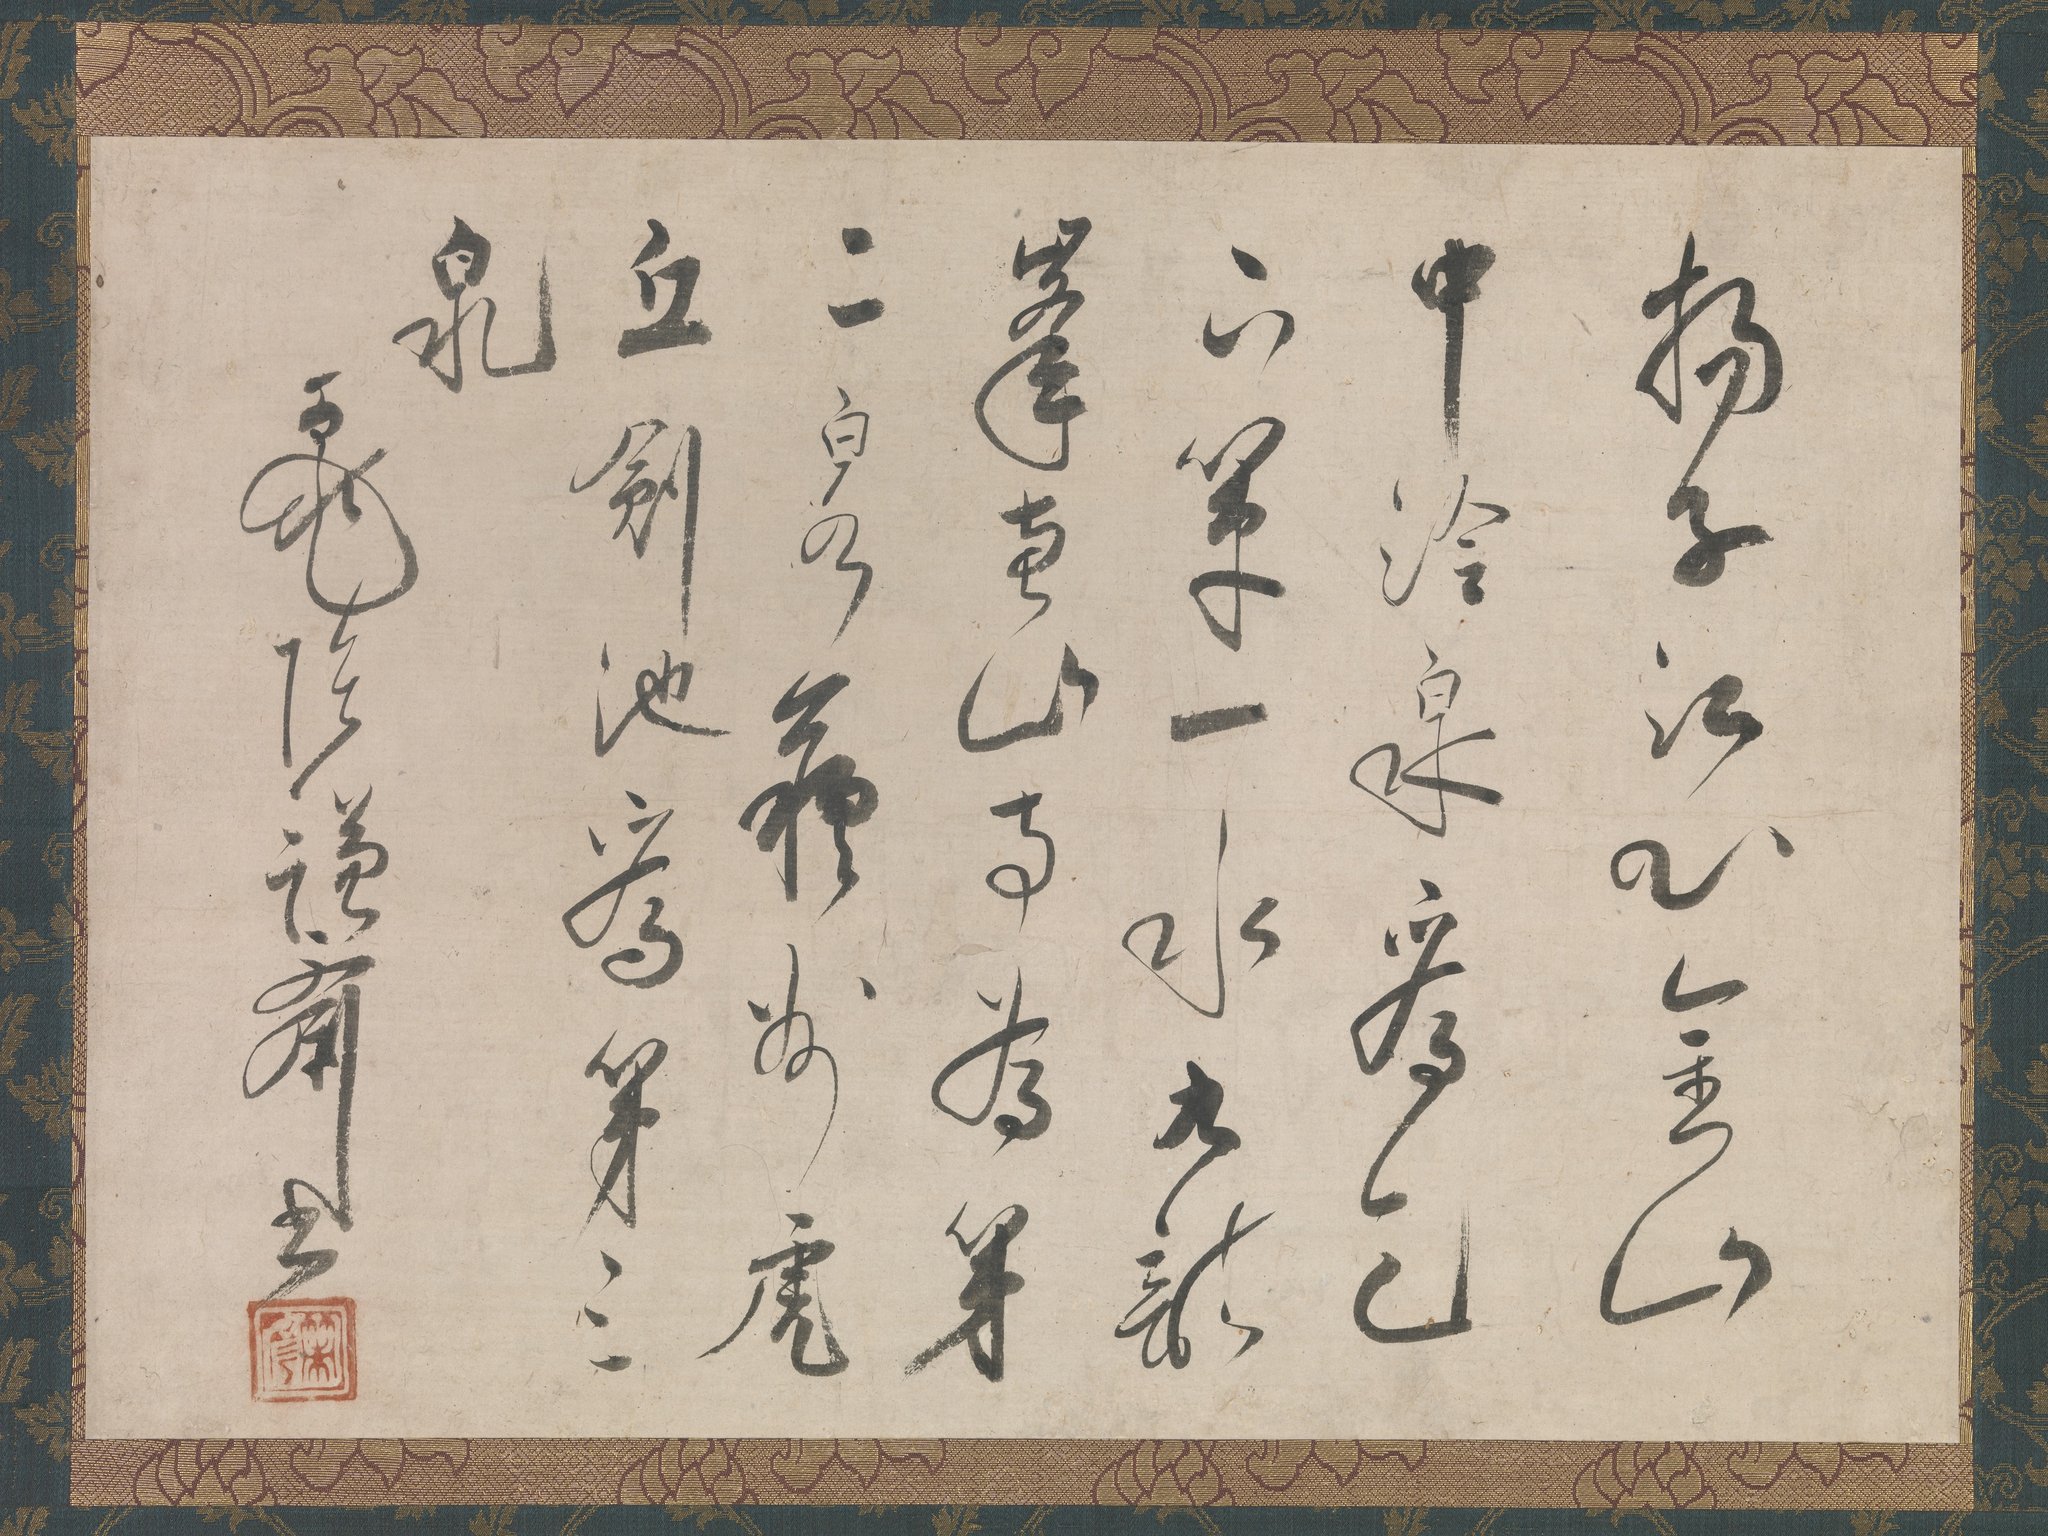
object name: hanging scroll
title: Account of the Three Springs of Jiangsu Province in China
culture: japanese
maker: sakugen shūryō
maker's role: artist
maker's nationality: japanese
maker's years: 1501-1579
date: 1567-1600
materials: ink, paper